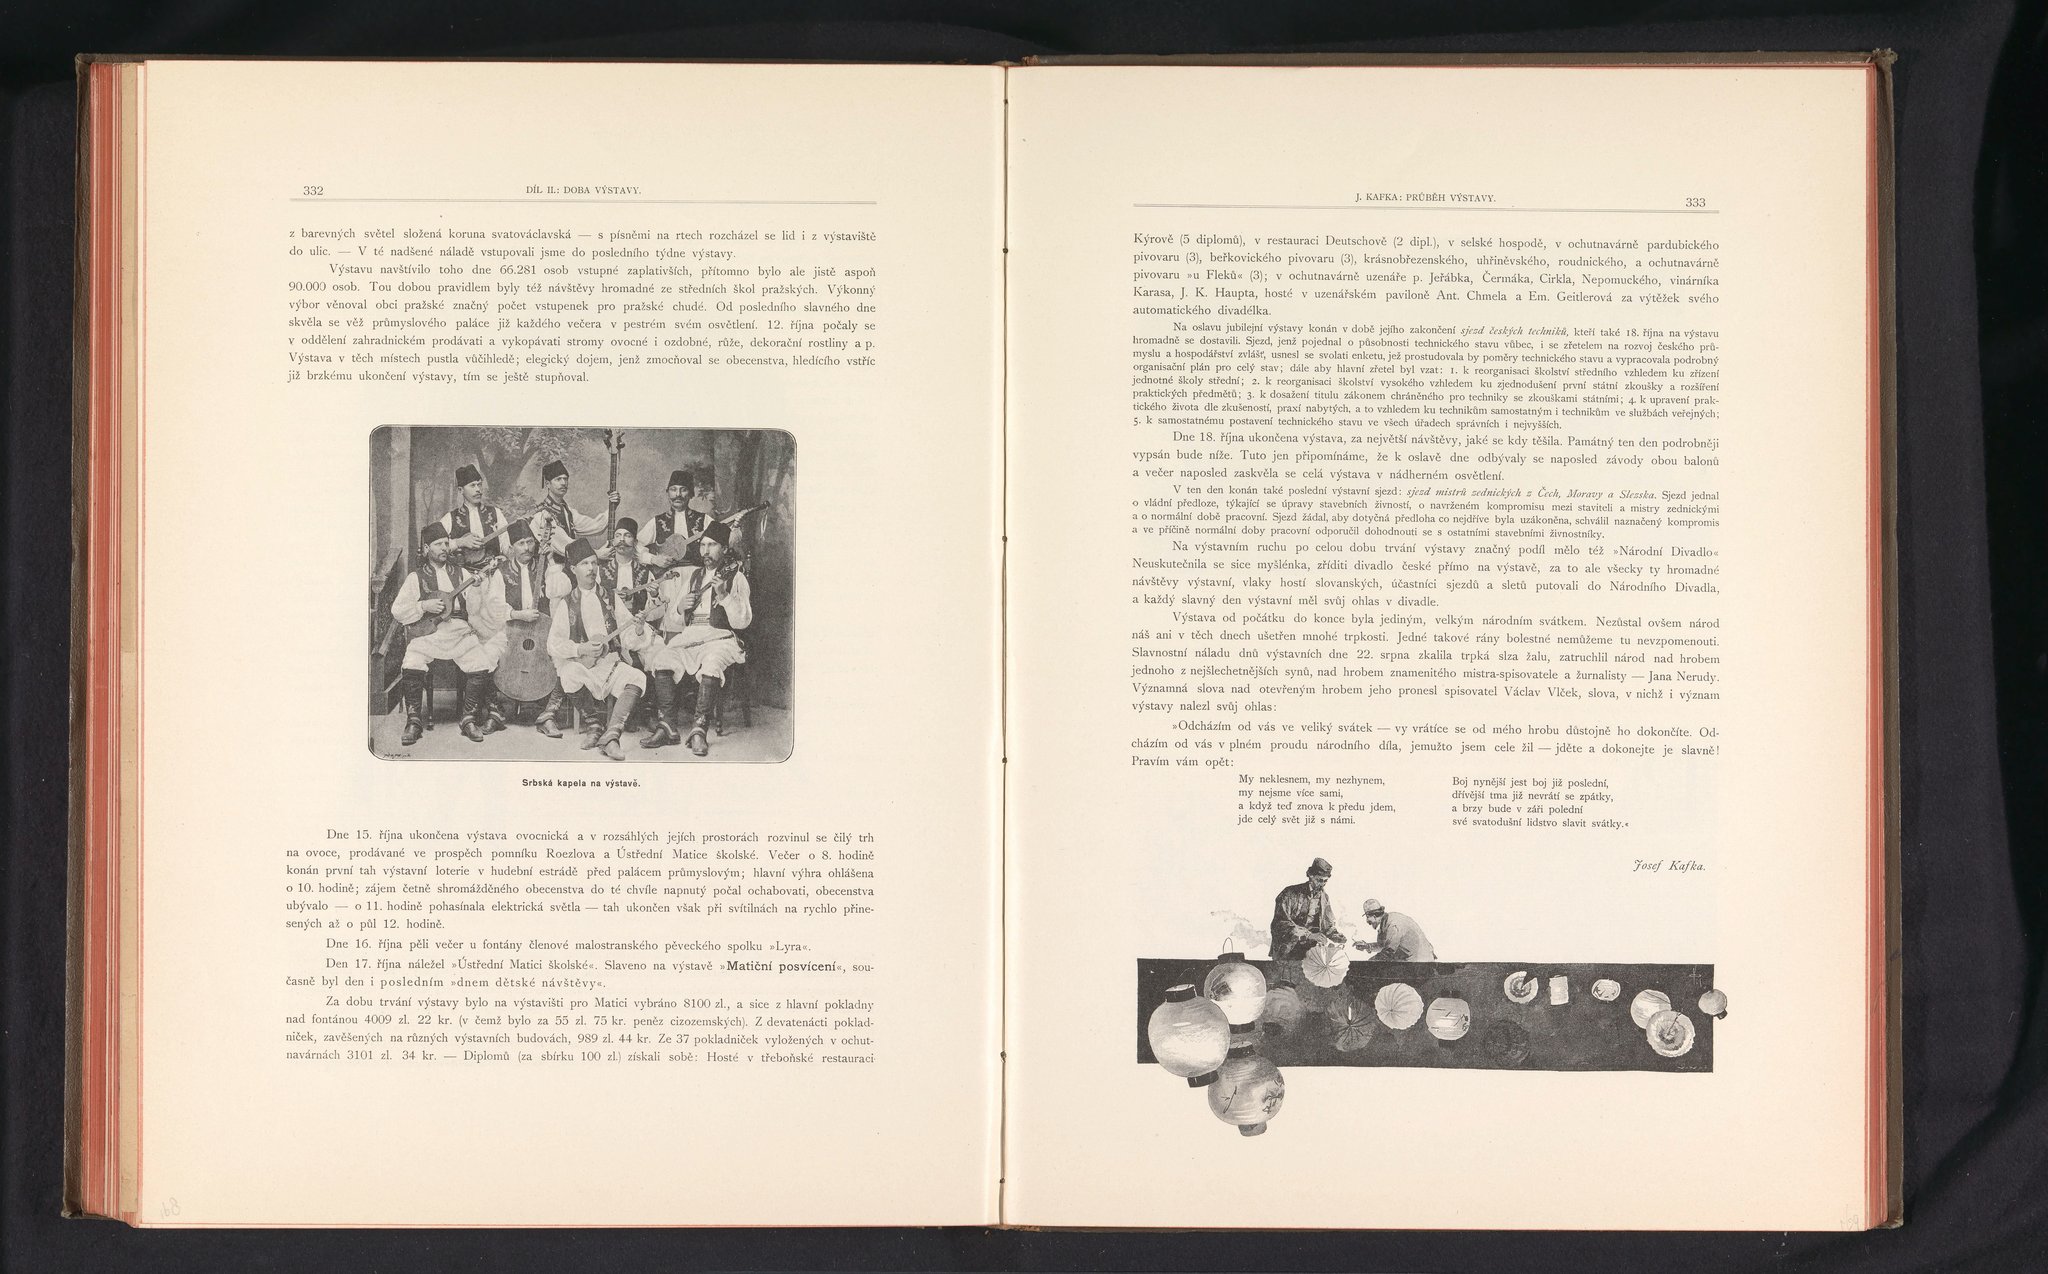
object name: reproduction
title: Fotoreproductie van een tekening, voorstellende twee mannen met lampions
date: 1891-1893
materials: paper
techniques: autotype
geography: prague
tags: adult man, lantern